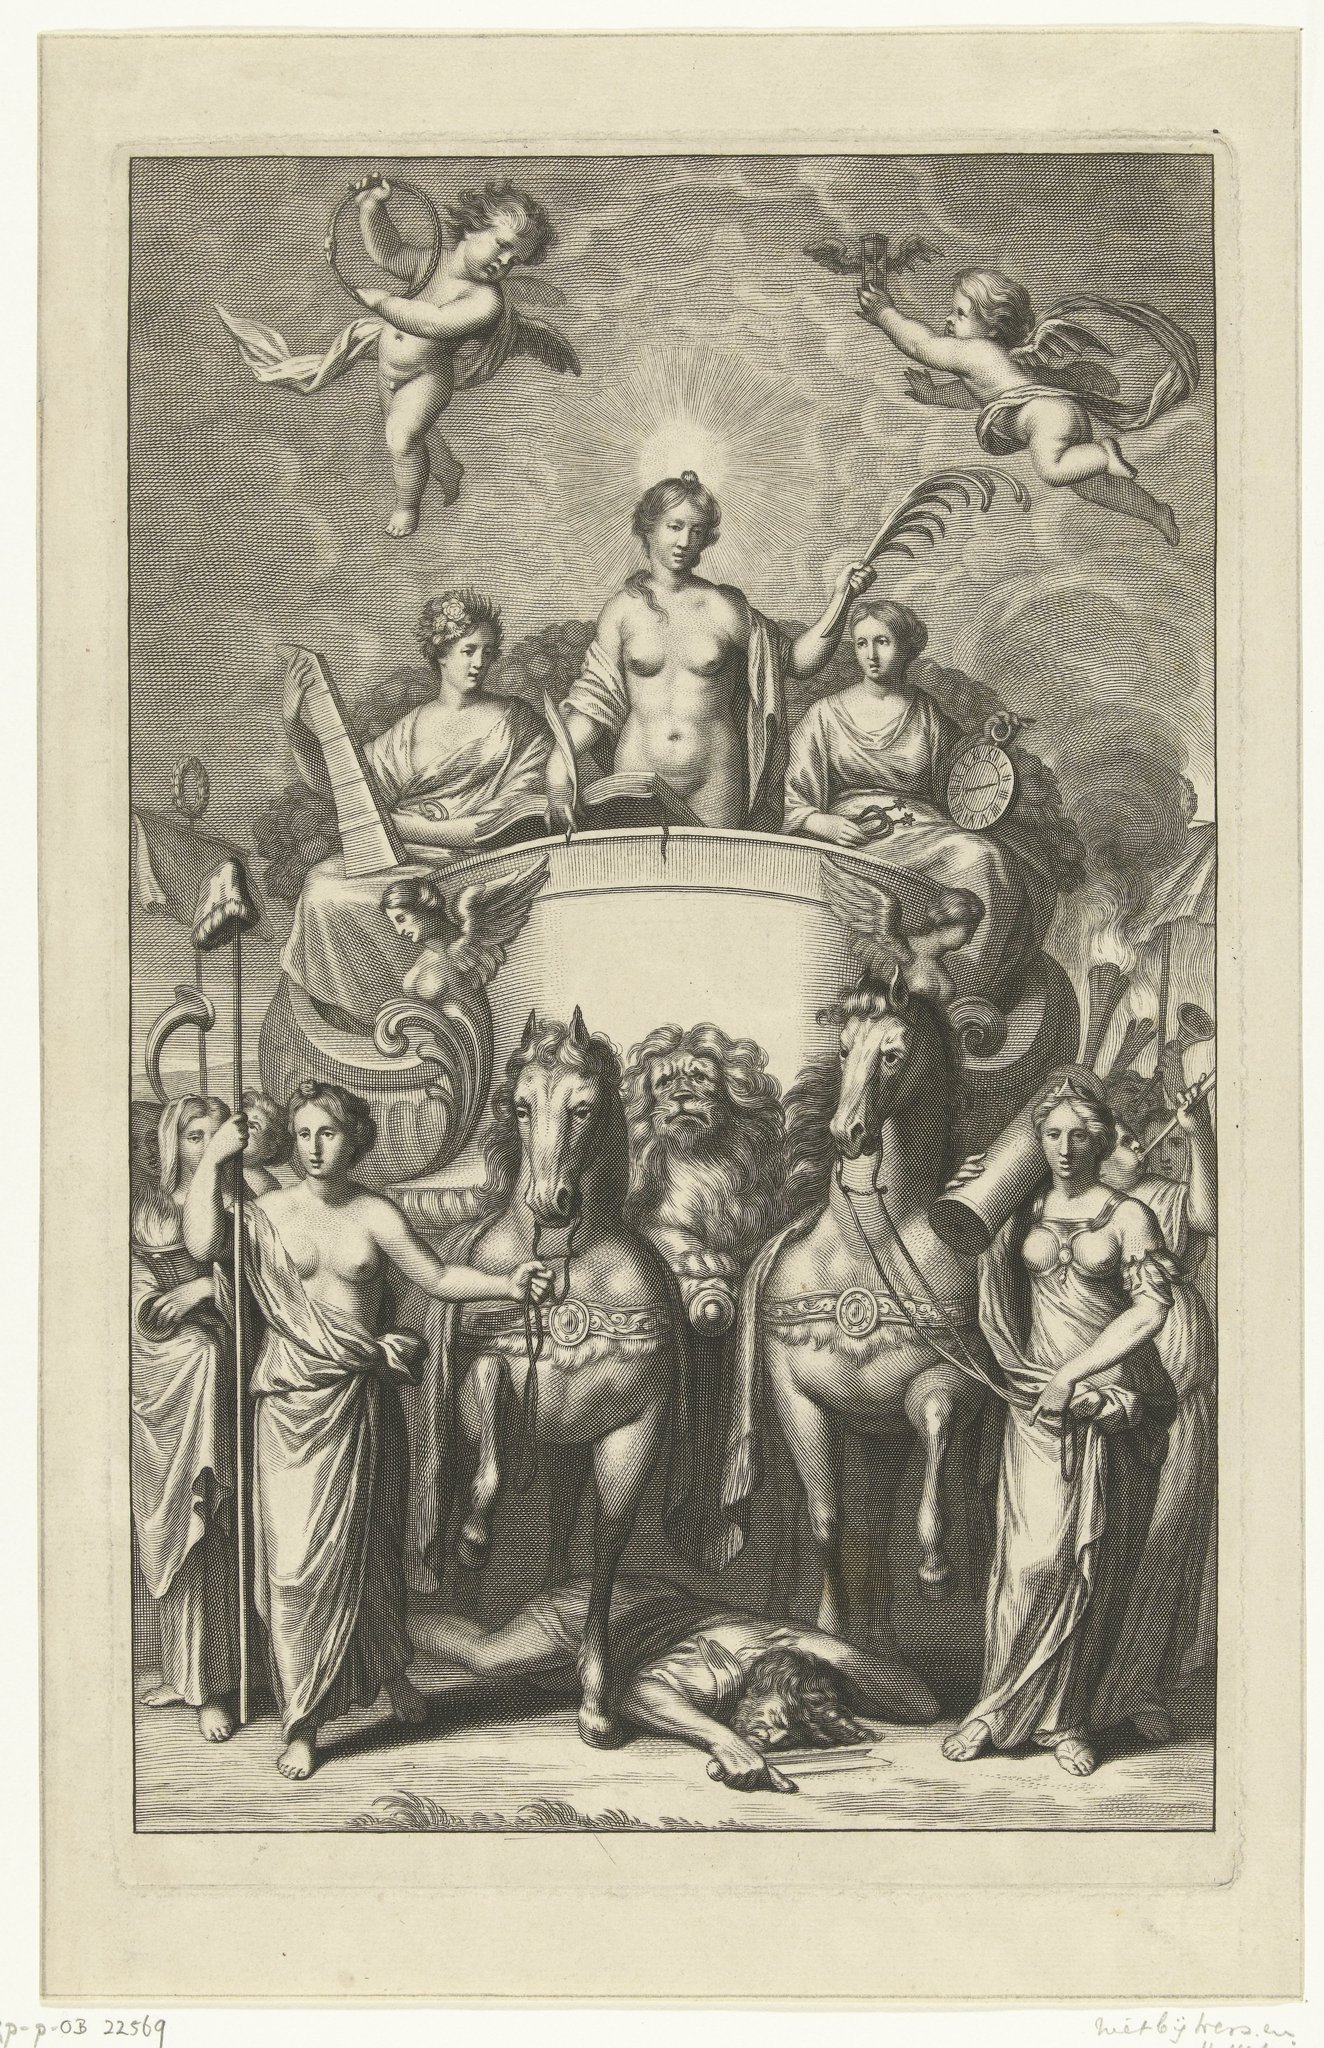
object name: print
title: Titelprent voor Hugo de Groots Nederlandtsche Jaerboeken en Historien, 1681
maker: abraham bloteling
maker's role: draughtsman, print maker, publisher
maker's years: 1640-1690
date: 1679-1681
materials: paper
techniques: engraving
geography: amsterdam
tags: truth; 'verità' (ripa)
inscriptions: collector's mark: Lugt 2228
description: Titelpagina voor: Hugo de Groot, Nederlandtsche jaerboeken en historien, sedert het jaer 1555 tot het jaer 1609, Amsterdam 1681. Staat vóór de letter.